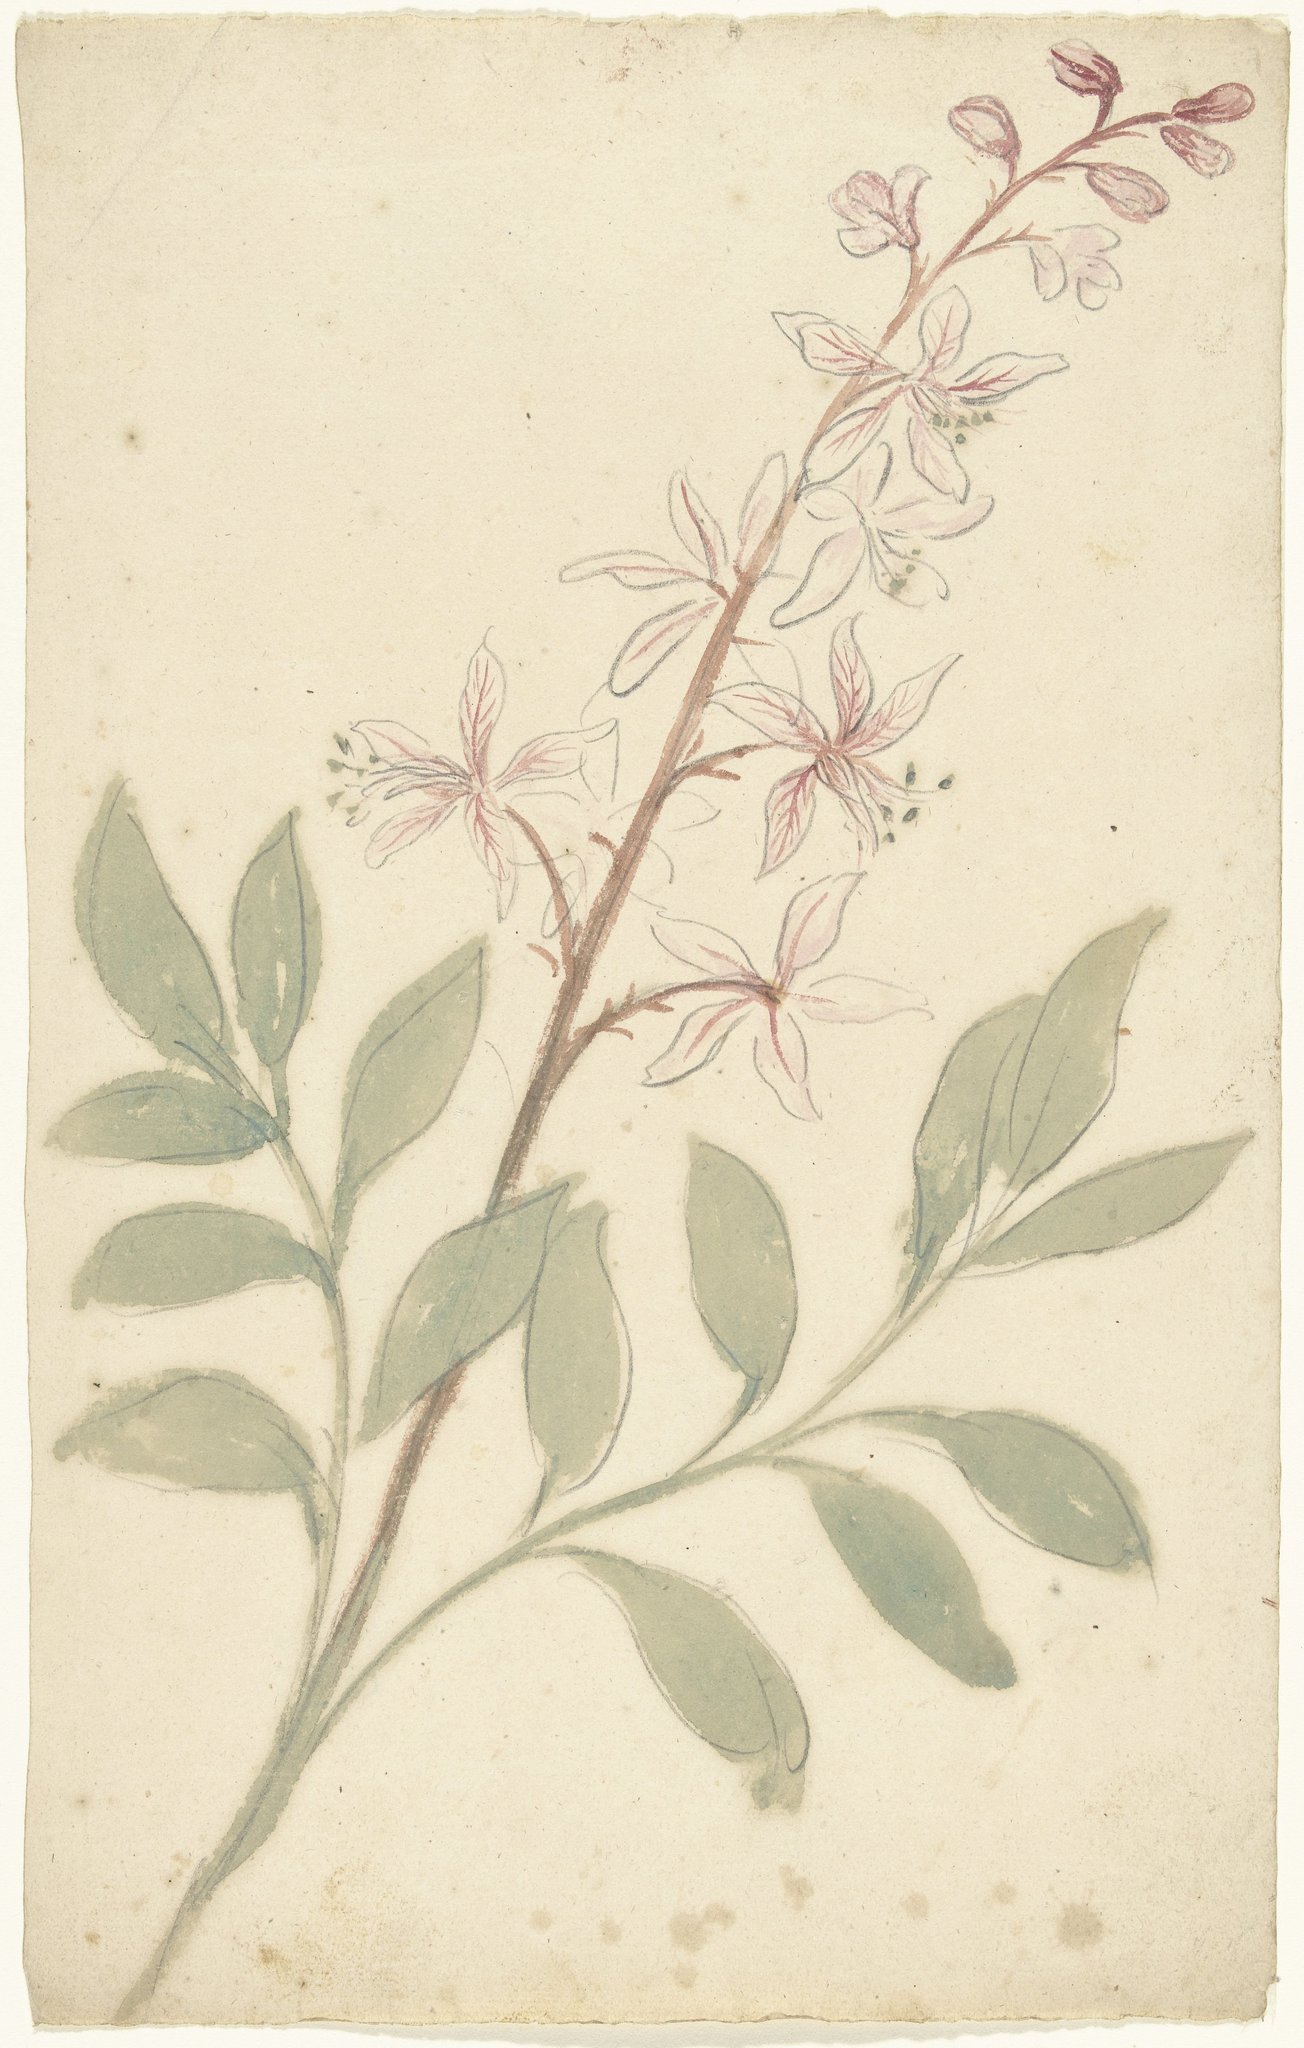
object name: watercolor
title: Bloemstudie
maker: elias van nijmegen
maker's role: draughtsman, painter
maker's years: 1667-1755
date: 1677-1755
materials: paper, pencil, watercolor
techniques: brush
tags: flowers